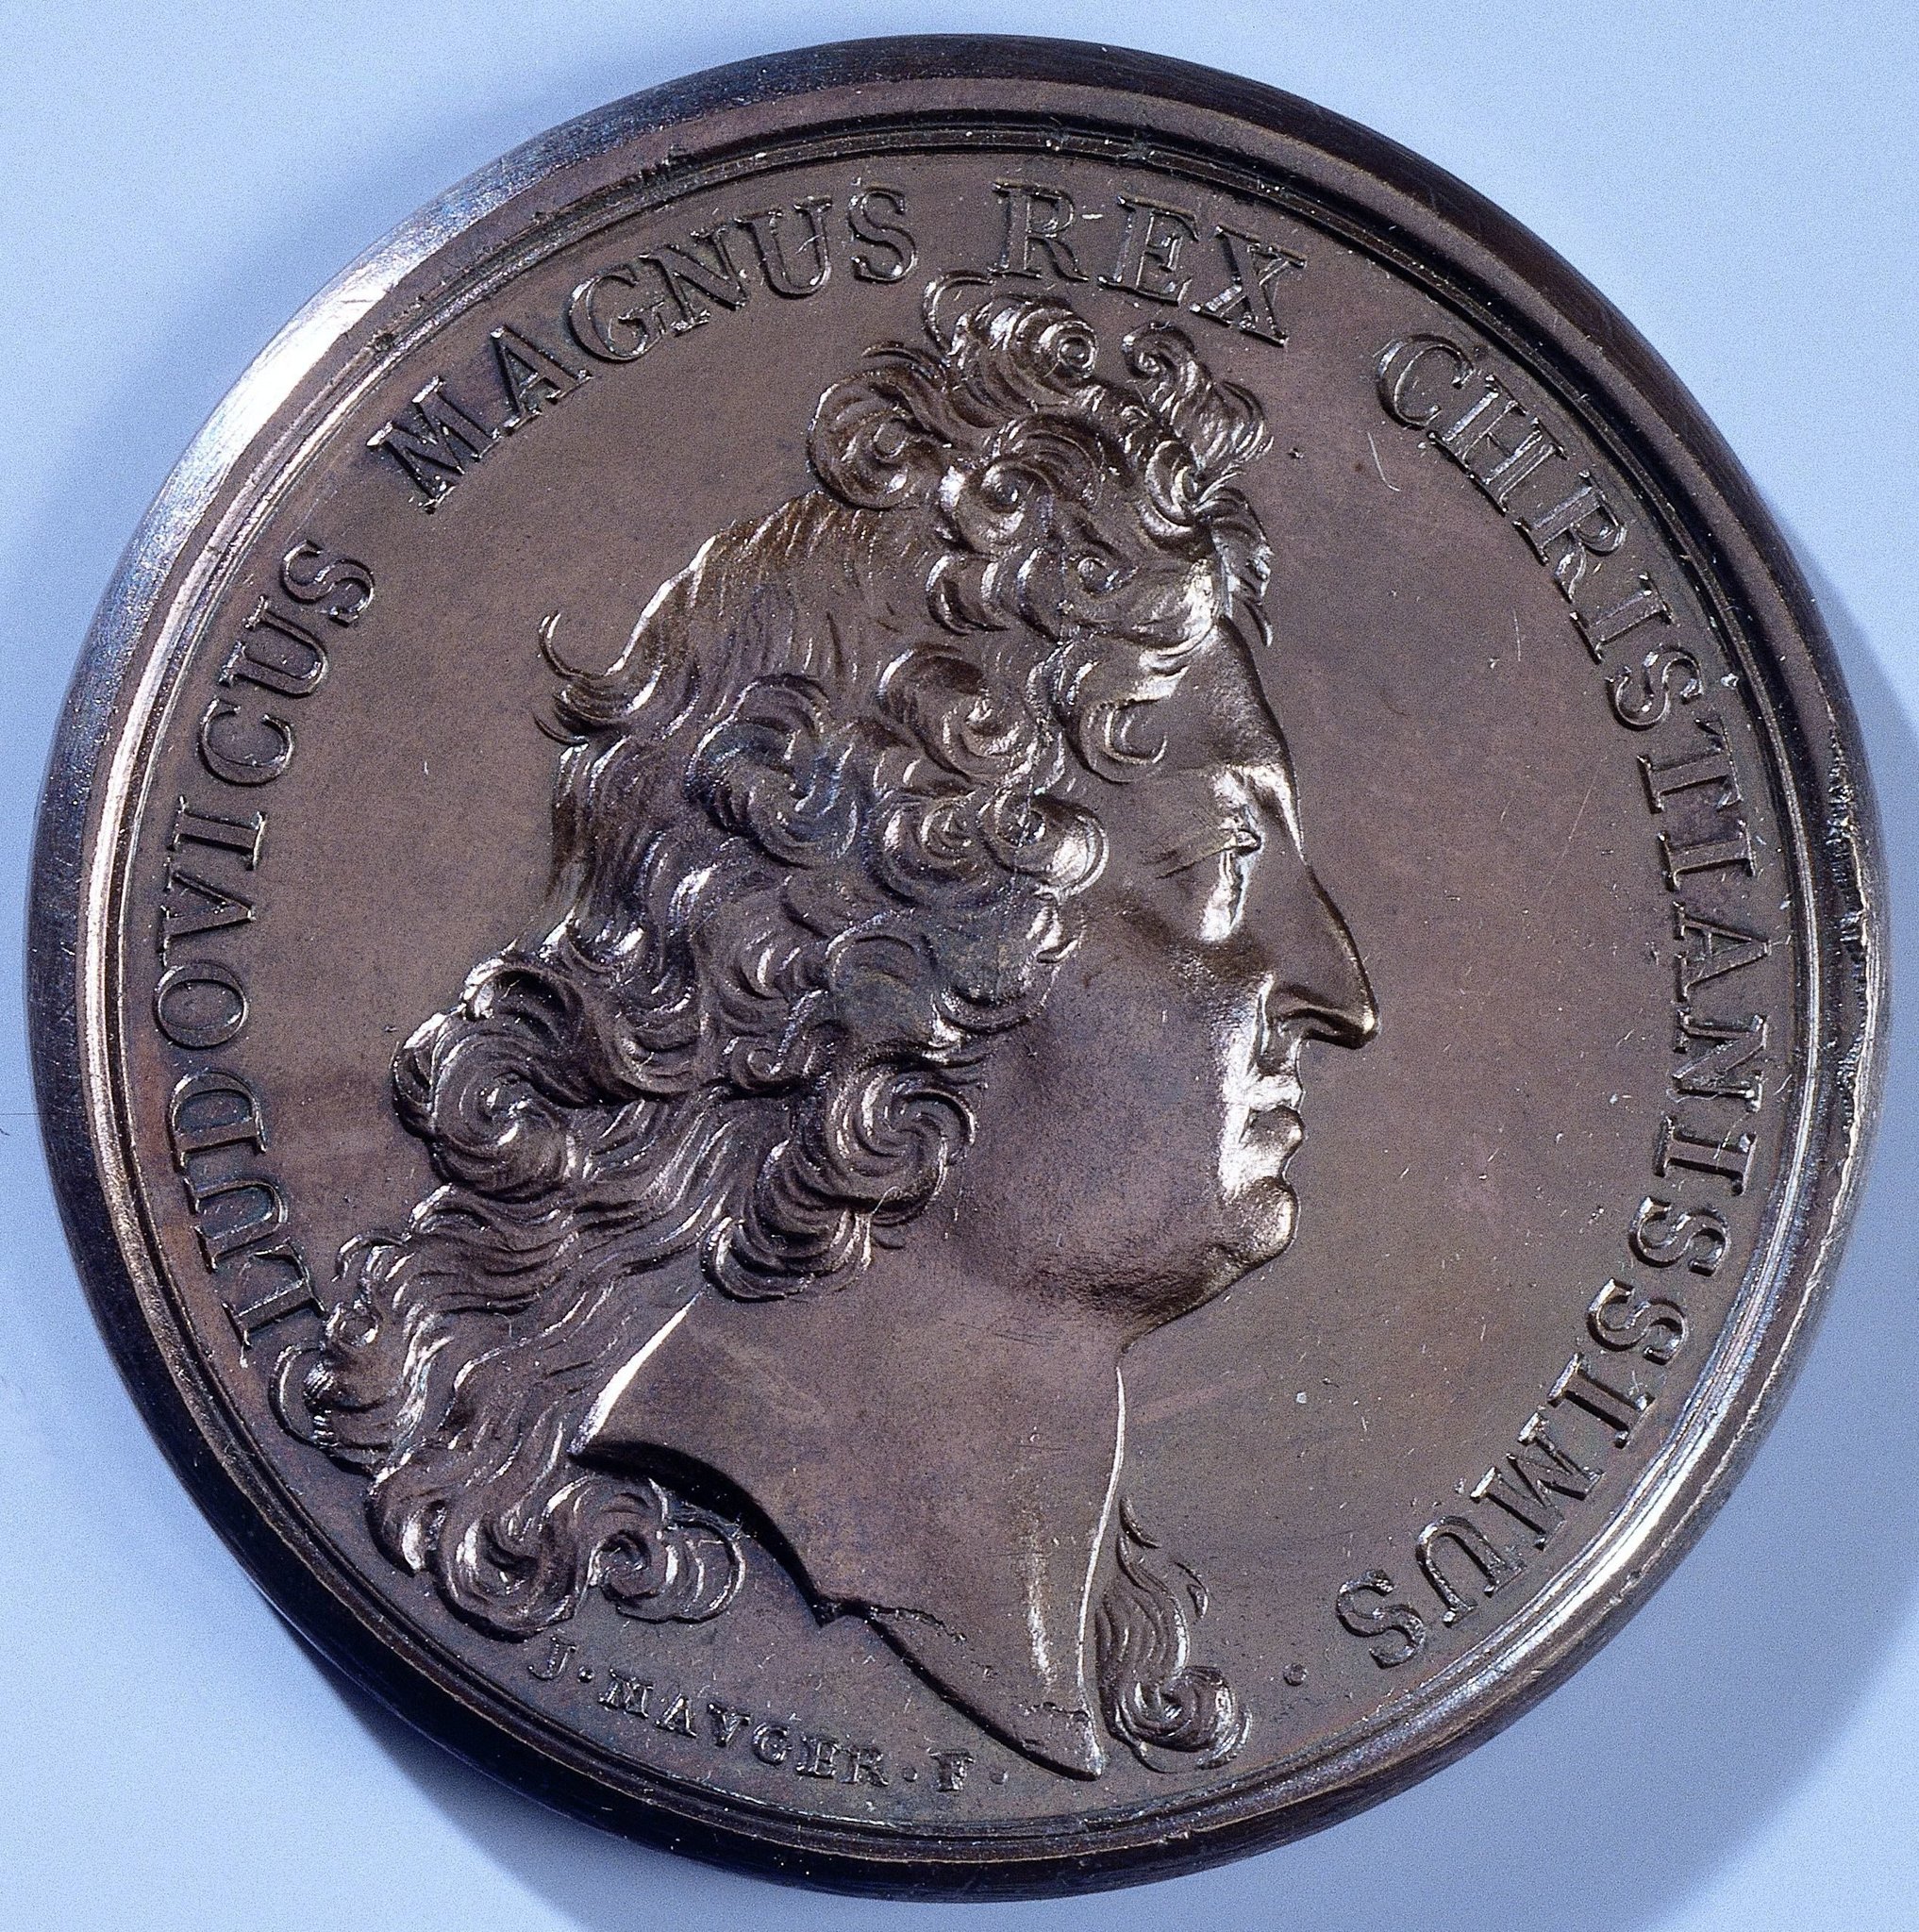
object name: history medal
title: Deinse en Dixmuiden door de Fransen ingenomen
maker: jean mauger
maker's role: medailleur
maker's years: 1648-1722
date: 1699-1703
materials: bronze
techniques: striking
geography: paris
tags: lodewijk xiv (koning van frankrijk)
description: Bronzen penning. Voorzijde: borststuk man binnen omschrift. Keerzijde: knielende soldaat die zijn wapens overgeeft, op grond twee kronen binnen omschrift; afsnede: opschrift.